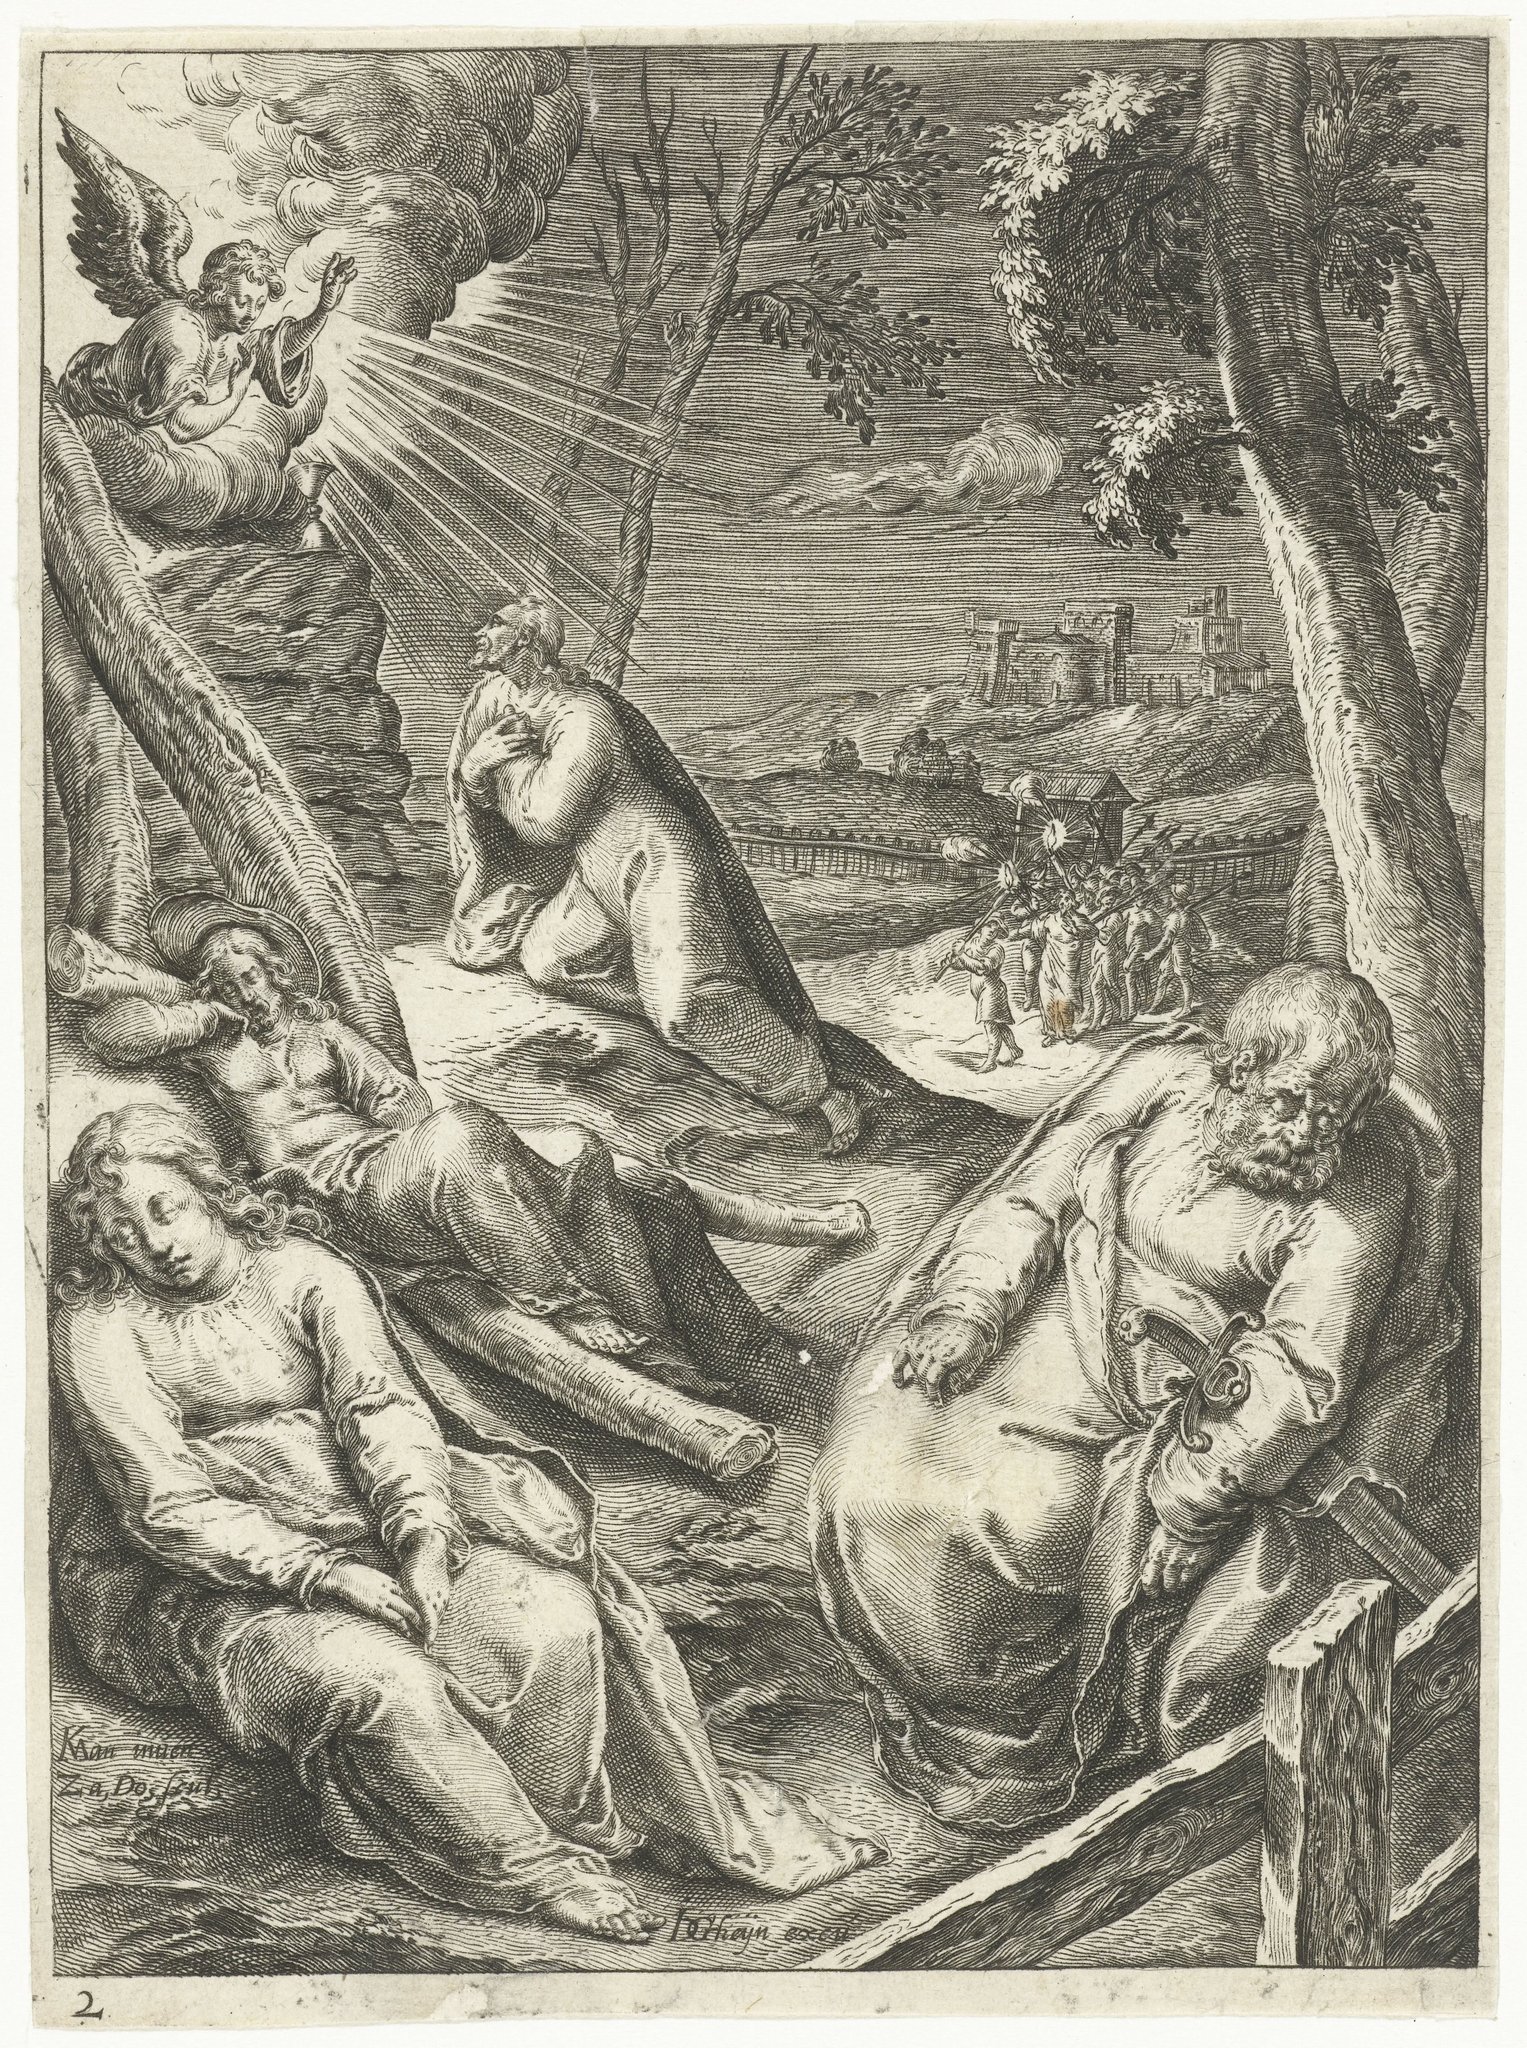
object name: print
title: Christus in de hof van Gethsemane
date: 1596-1598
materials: paper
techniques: engraving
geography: leiden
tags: gethsemane, mount of olives, 'oelberg' (matthew 26:36-56; mark 14:32-52; luke 22:39-53; john 18:1-12)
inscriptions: collector's mark: Lugt 2228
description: Christus bidt op de olijfberg en een engel verschijnt voor hem. De discipelen die met hem zouden waken zijn in slaap gevallen. Op de achtergrond zijn al de soldaten te zien die Christus gevangen willen nemen en vanuit de stad naar de berg trekken. Prent uit een serie van 13 prenten en een titelprent vervaardigt door Z. Dolendo en J. de Gheyn II.